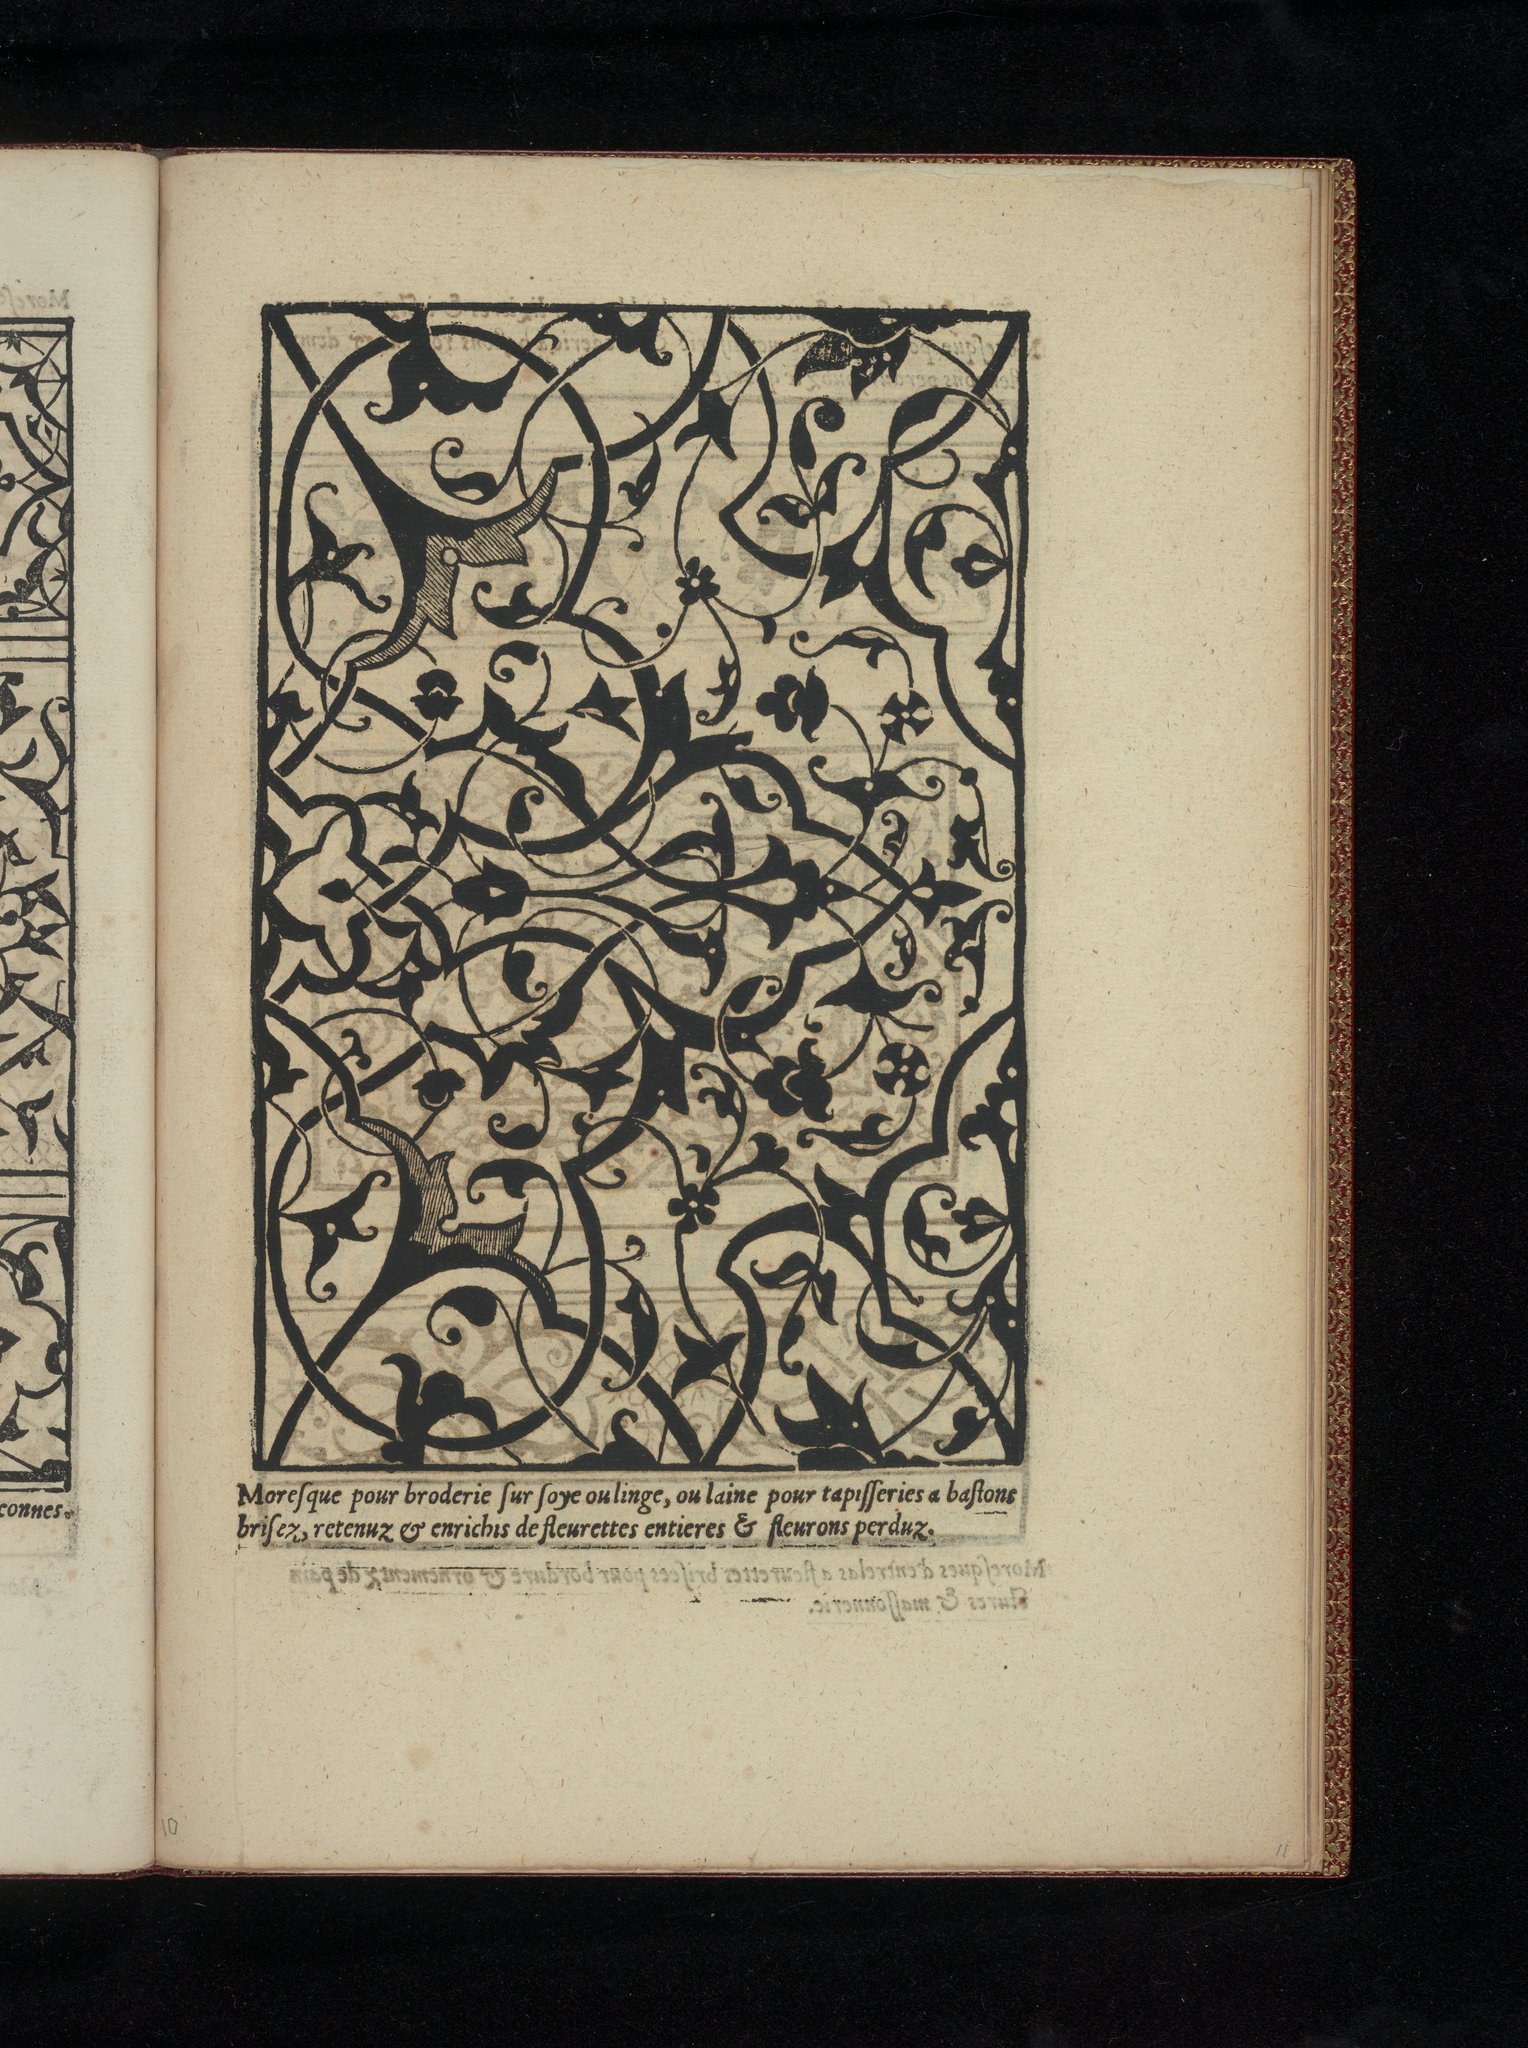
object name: book print ornament architecture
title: Livre de Moresques, page 11 (recto)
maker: francesco di pellegrino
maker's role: artist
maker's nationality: italian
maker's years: 1525-1552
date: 1546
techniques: woodcut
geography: france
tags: ornament